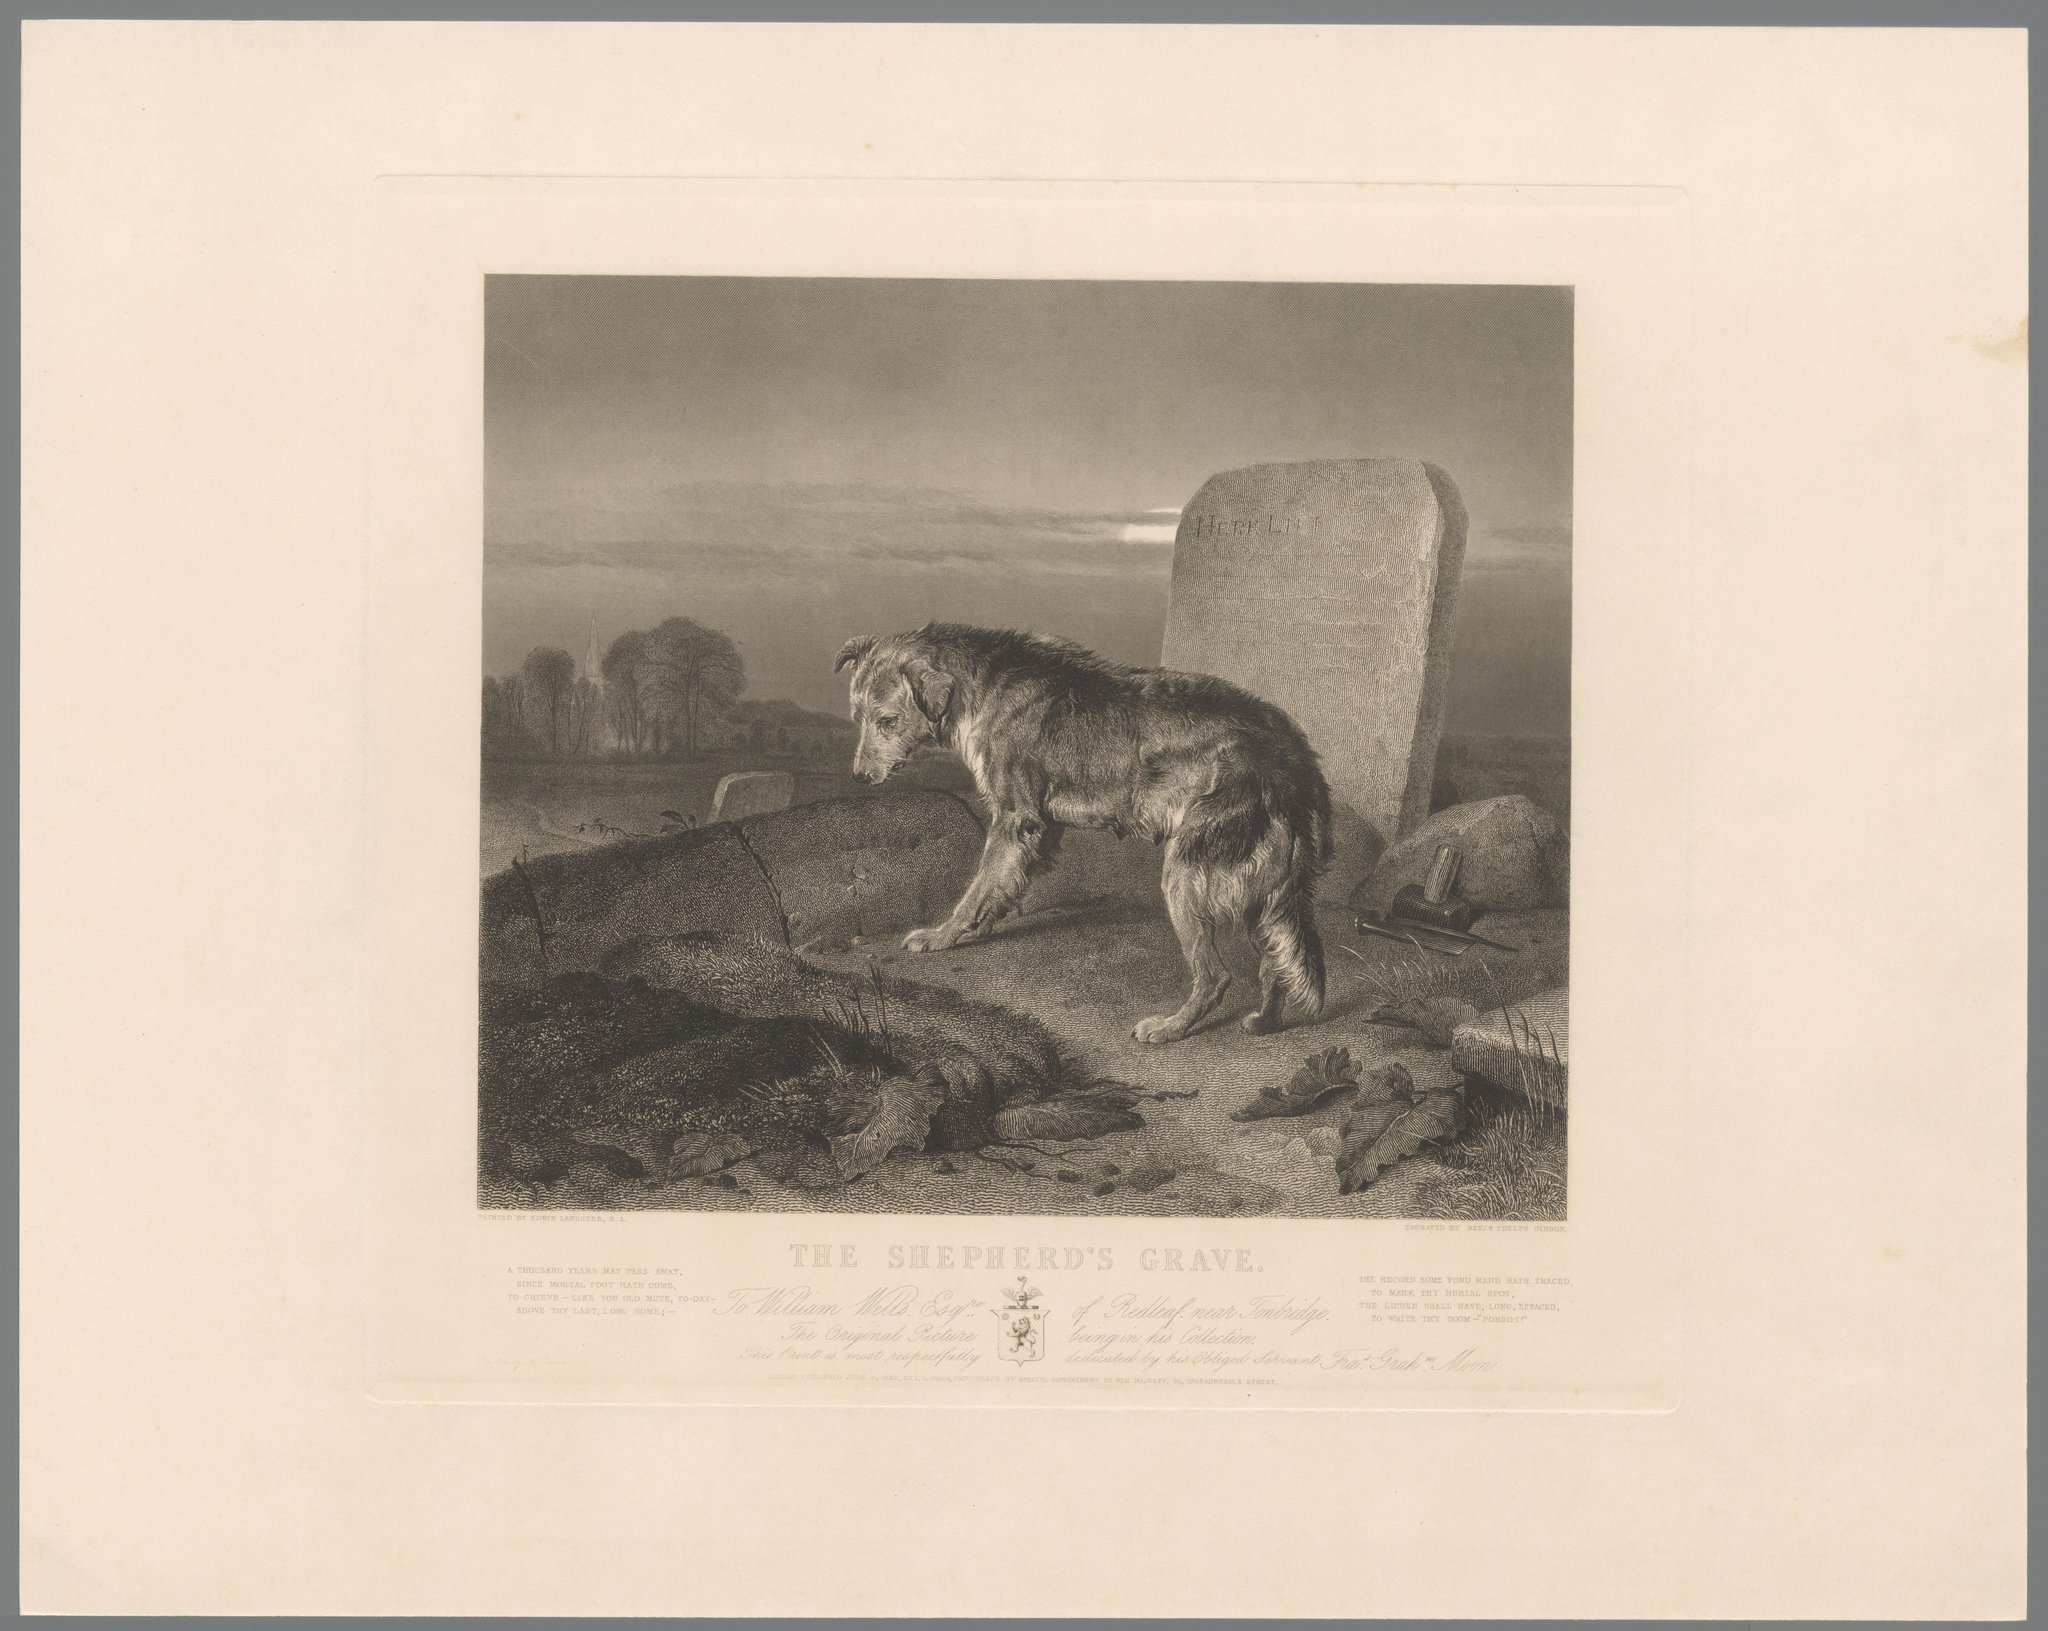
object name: print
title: Hond bij het graf van de herder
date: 1838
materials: paper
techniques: engraving, etching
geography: london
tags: grave, tomb, pain, sorrow, sadness; 'dolore', 'dolore di zeusi' (ripa), dog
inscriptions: collector's mark: Lugt 2228